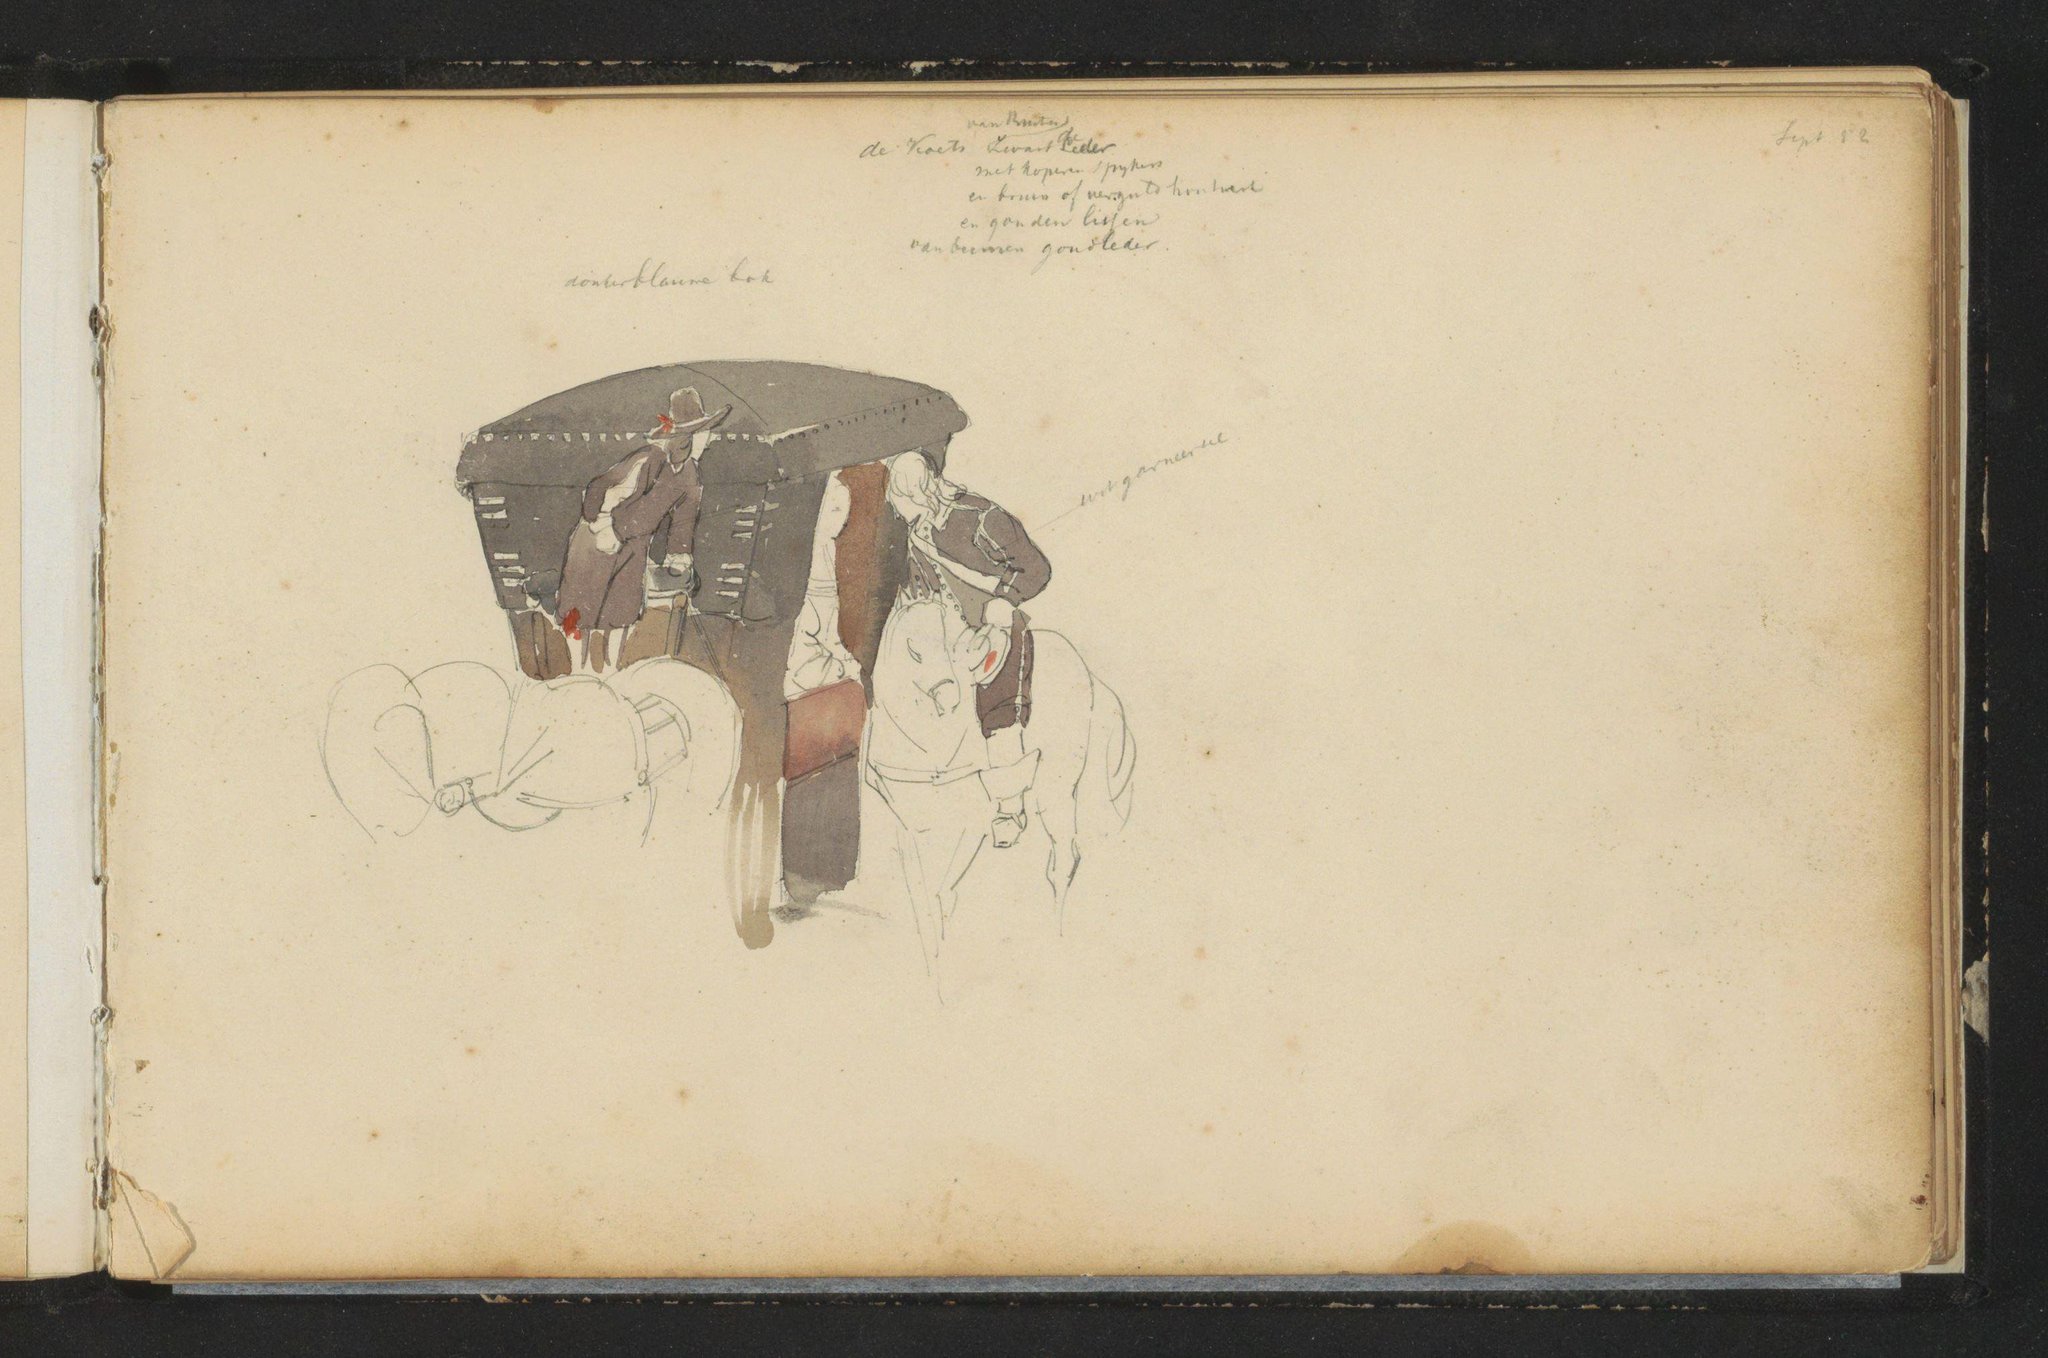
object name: sketchbook leaf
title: Ruiter naast een koets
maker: cornelis springer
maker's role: draughtsman, painter, print maker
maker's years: 1817-1891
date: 1809-1852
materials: paper, pencil, watercolor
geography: netherlands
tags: riding a horse, ass, or mule; rider, horseman, four-wheeled vehicle drawn by one animal, adult woman, adult man, clothes, costume (+ men's clothes)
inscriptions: date: ‘Sept 52’, annotation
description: Ruiter naast een koets. In de koets zit een vrouw. De koetsier staat op de bok en kijkt toe. Blad 17 uit een schetsboek met 91 bladen.